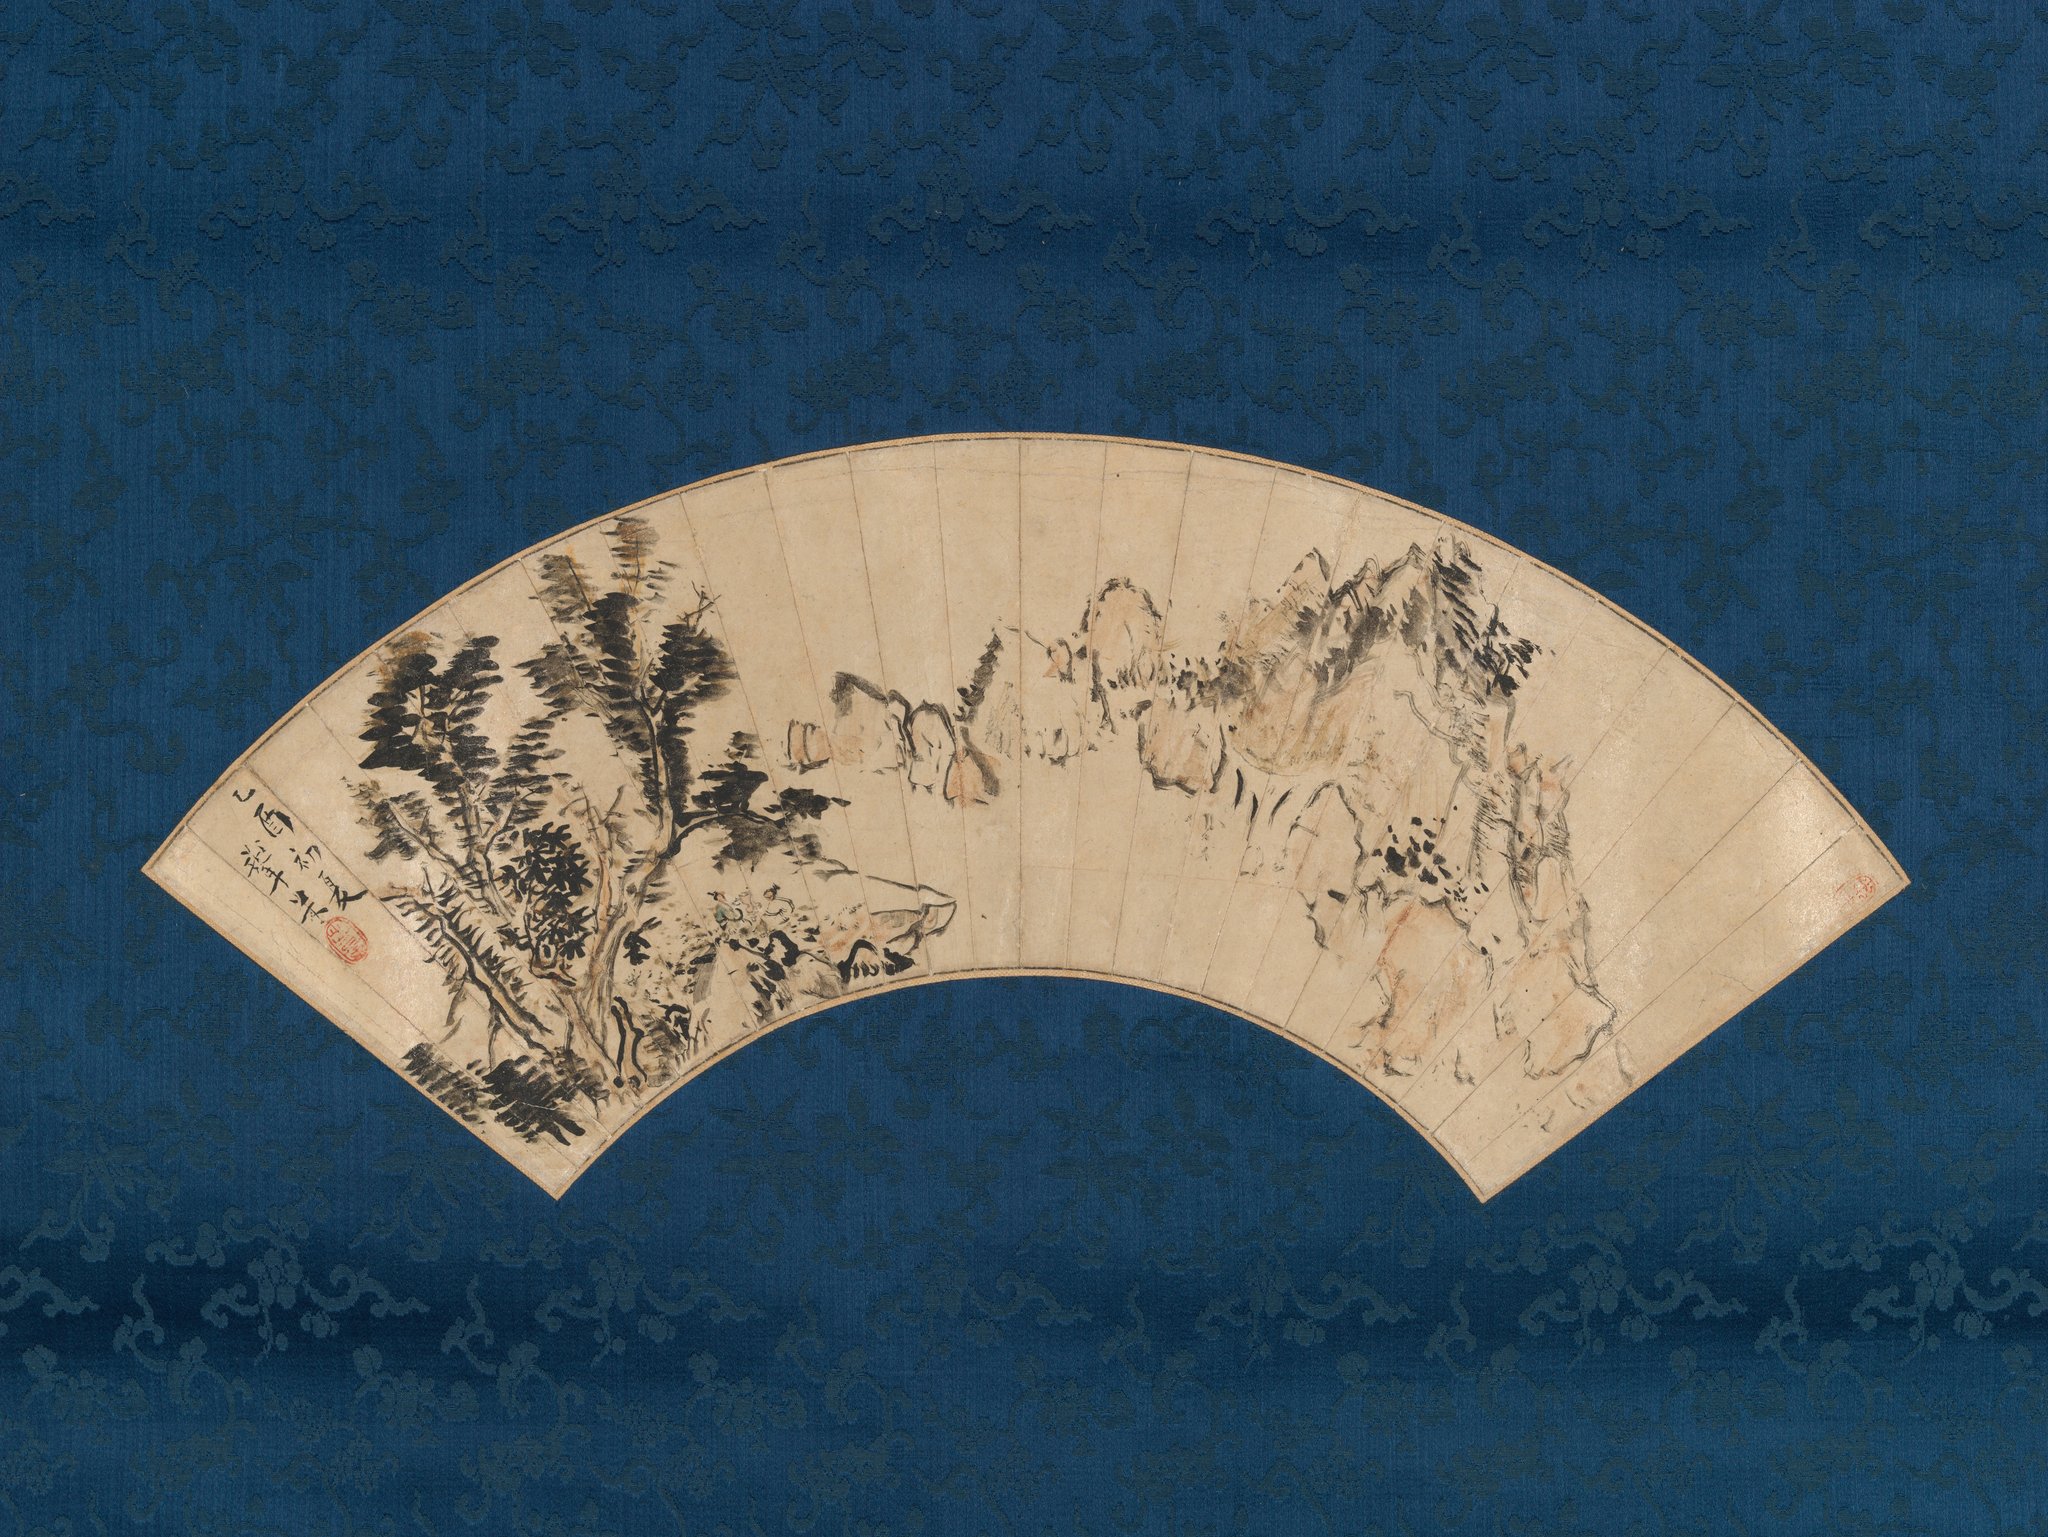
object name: hanging scroll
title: Preparing Tea by a Mountain Gorge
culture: japanese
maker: aoki mokubei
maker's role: artist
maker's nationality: japanese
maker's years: 1767-1833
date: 1825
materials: ink, paper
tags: landscapes